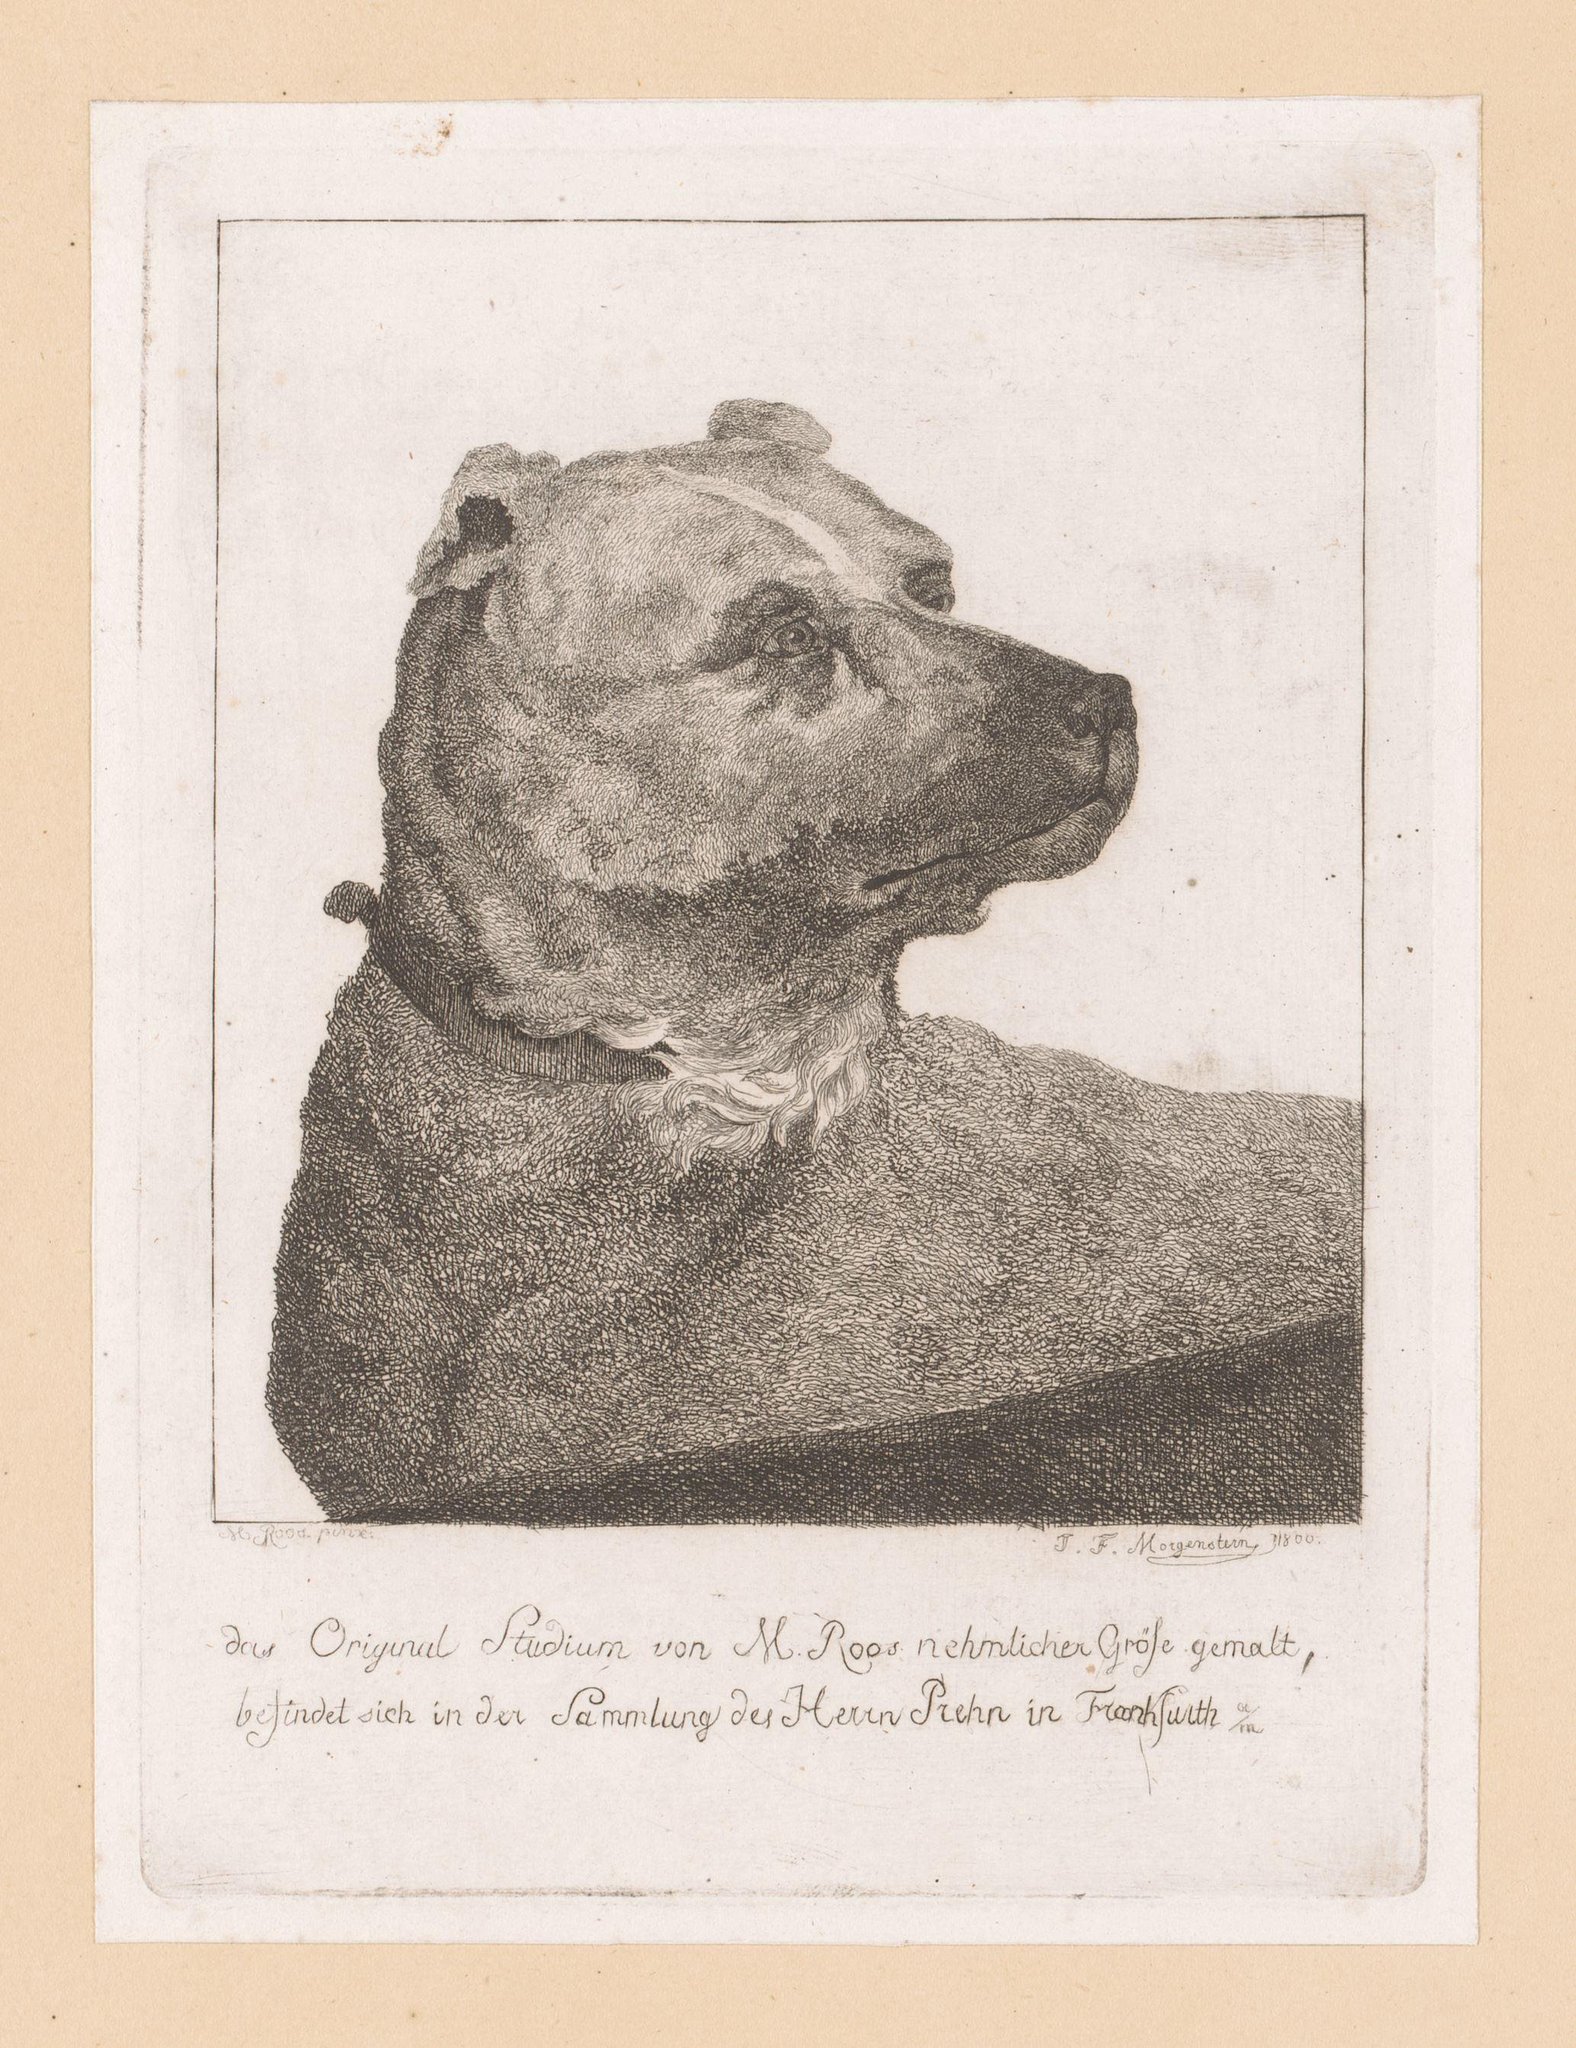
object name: print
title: Kop van een hond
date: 1800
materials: paper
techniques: etching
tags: dog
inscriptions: collector's mark: Lugt 2228